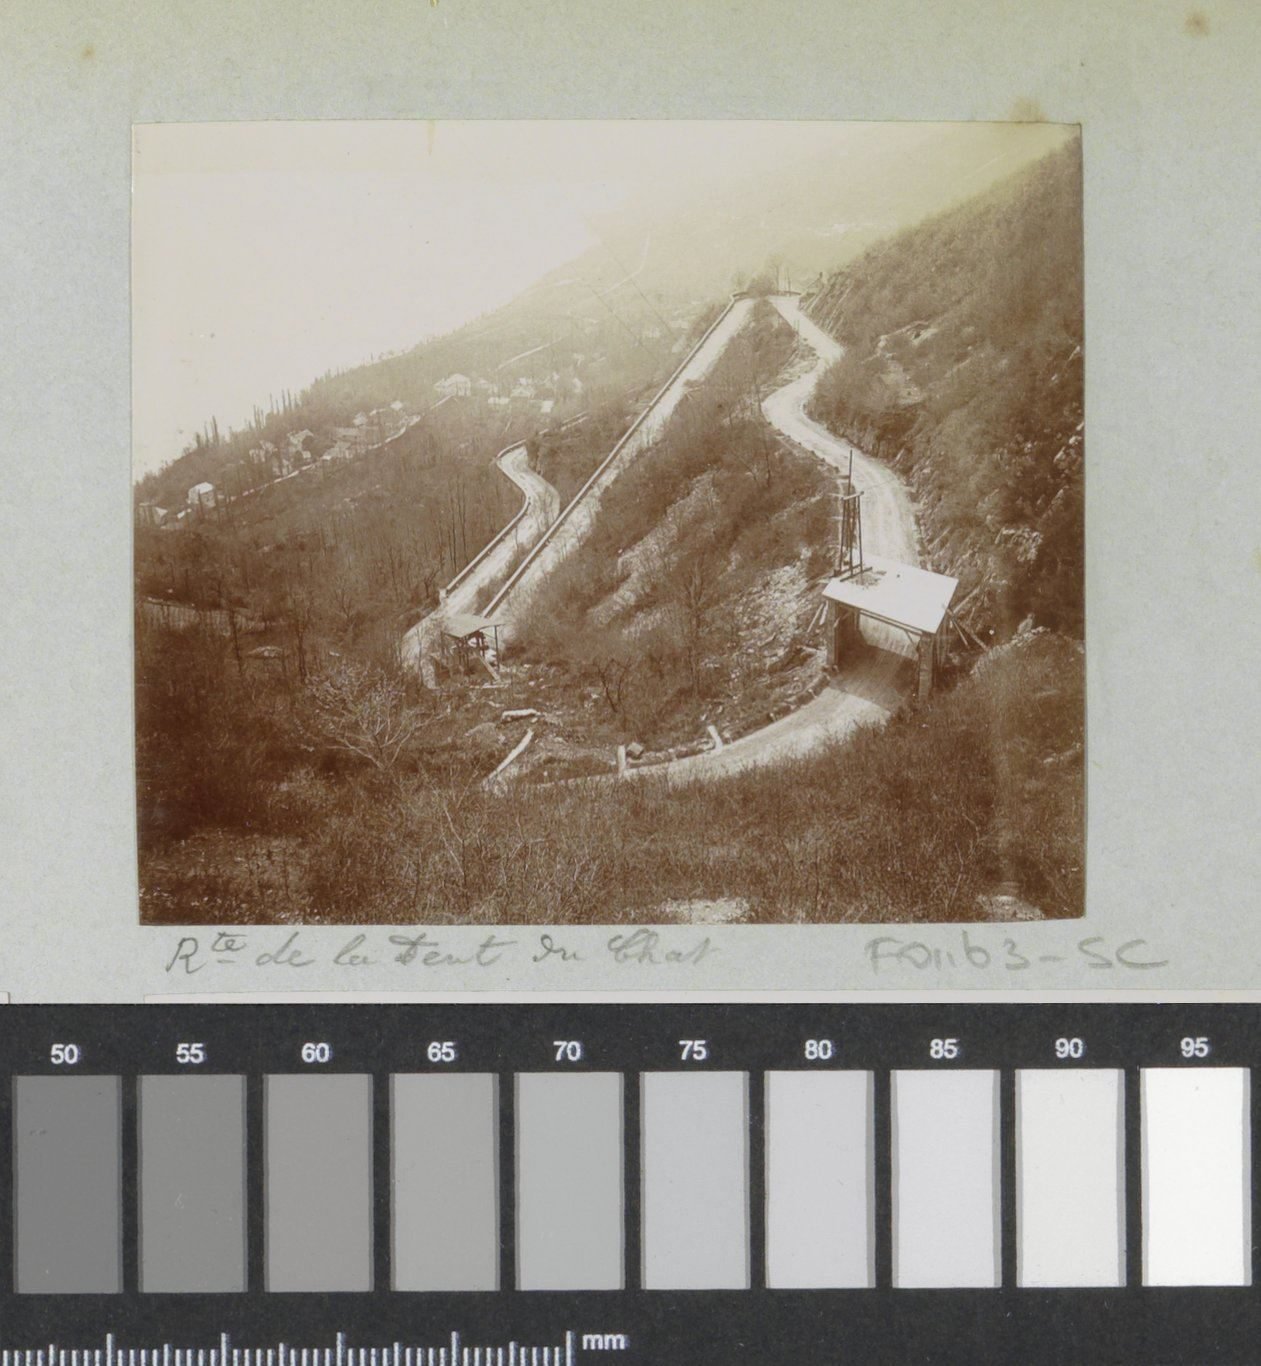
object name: photograph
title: Gezicht op de Route de la Dents du Chat in de Franse Alpen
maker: delizy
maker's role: manufacturer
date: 1903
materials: paper, photographic support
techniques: gelatin silver print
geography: alps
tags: road, path, mountains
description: Onderdeel van Fotoalbum van een Franse amateurfotograaf met opnames van uitstapjes in Frankrijk, Spanje, België, Luxemburg en Nederland, de eerste automobielen en autoraces.